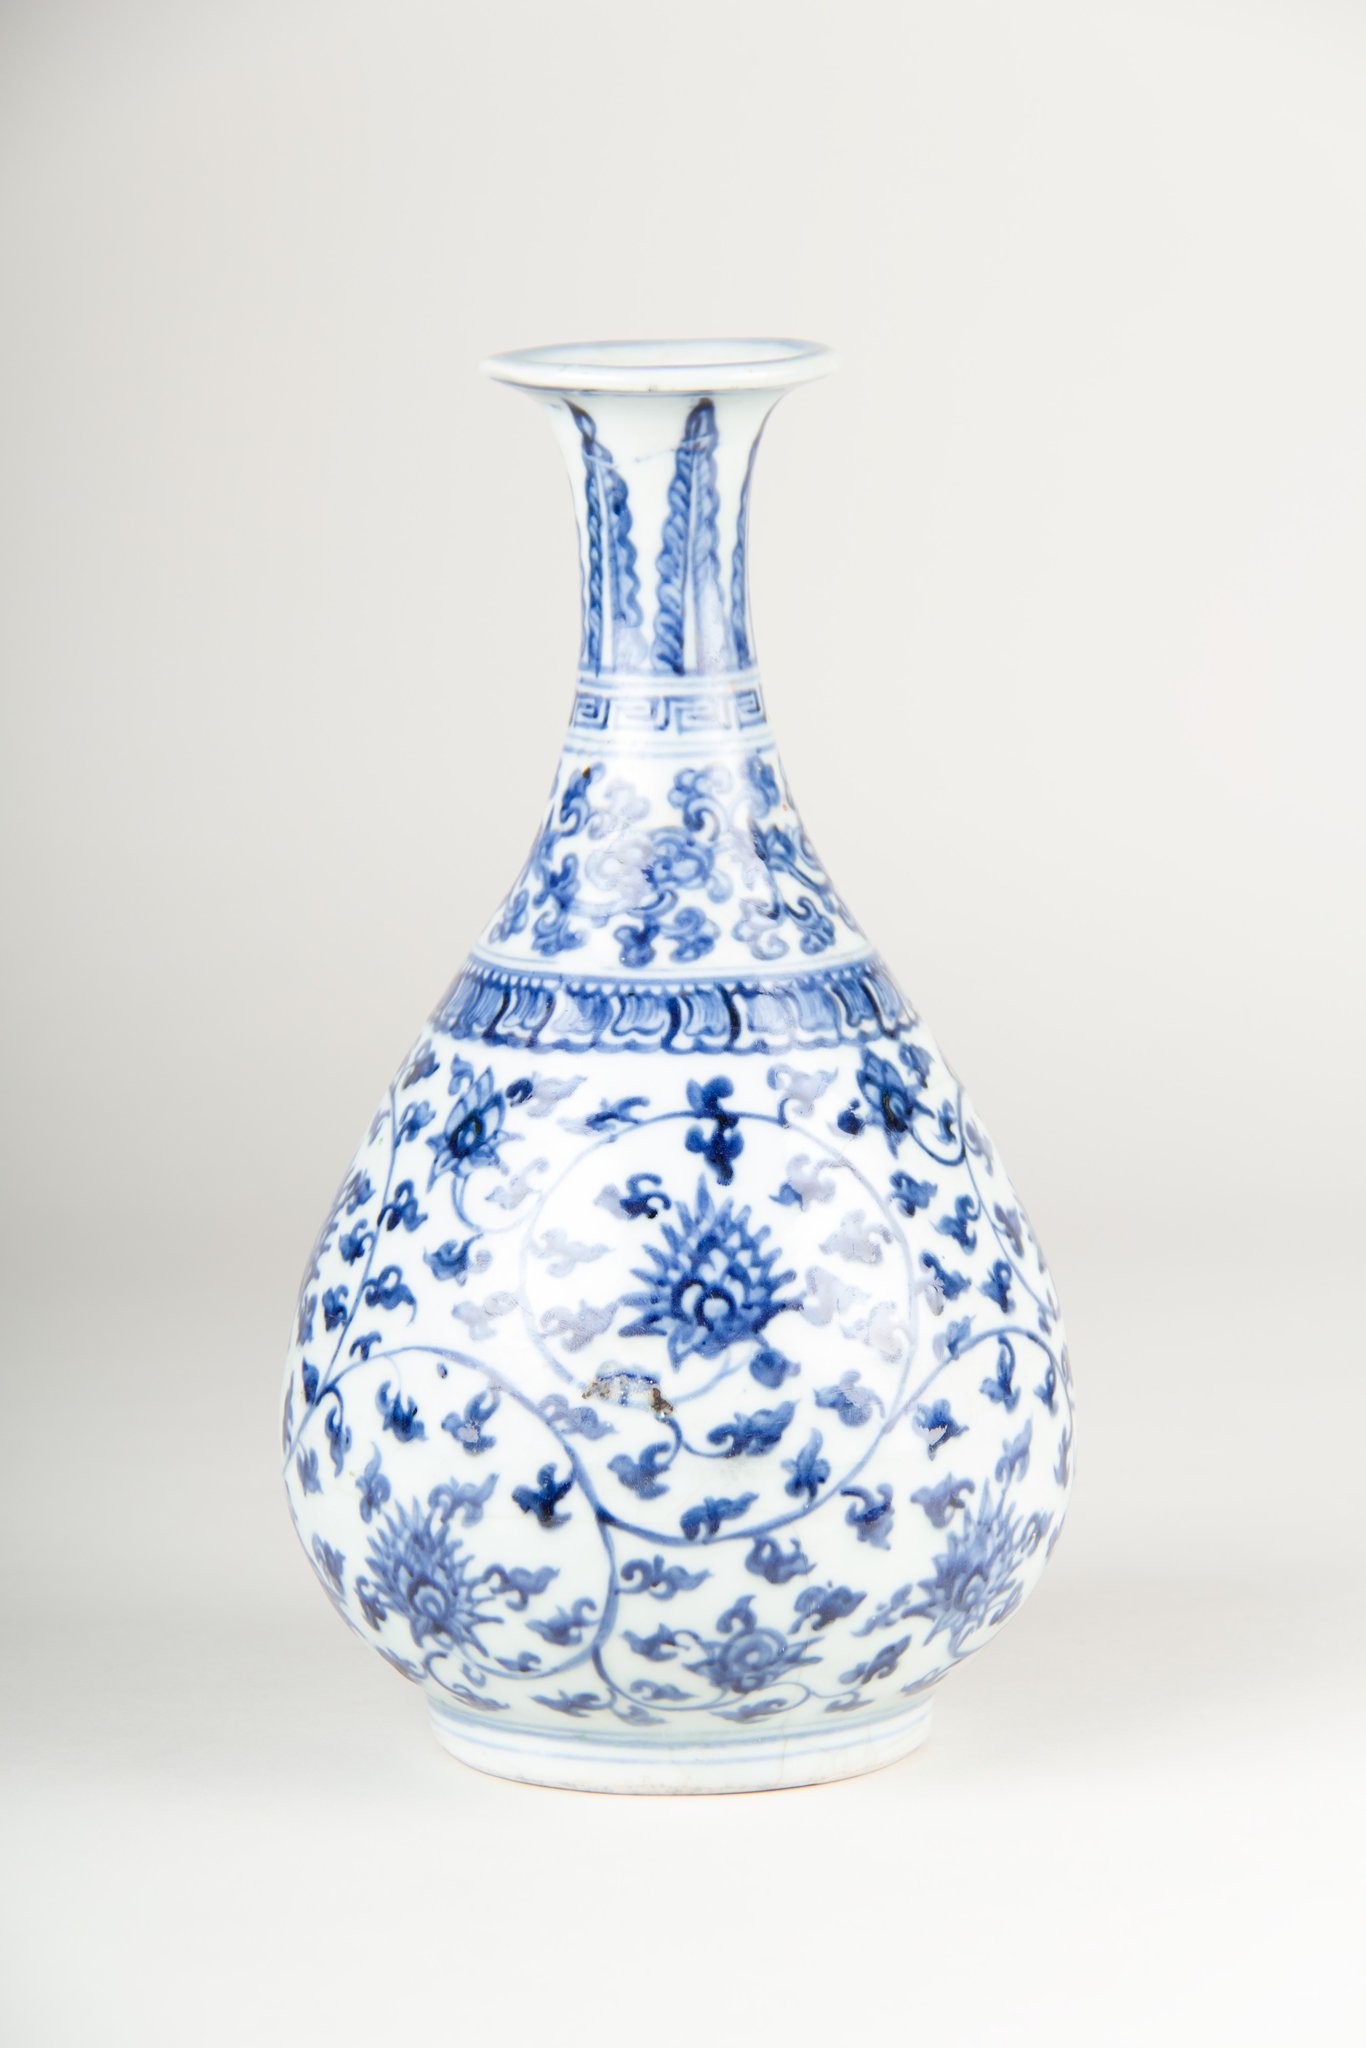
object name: bottle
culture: chinese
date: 1501-1600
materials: cobalt, glaze, porcelain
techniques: painting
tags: flowers,leaves